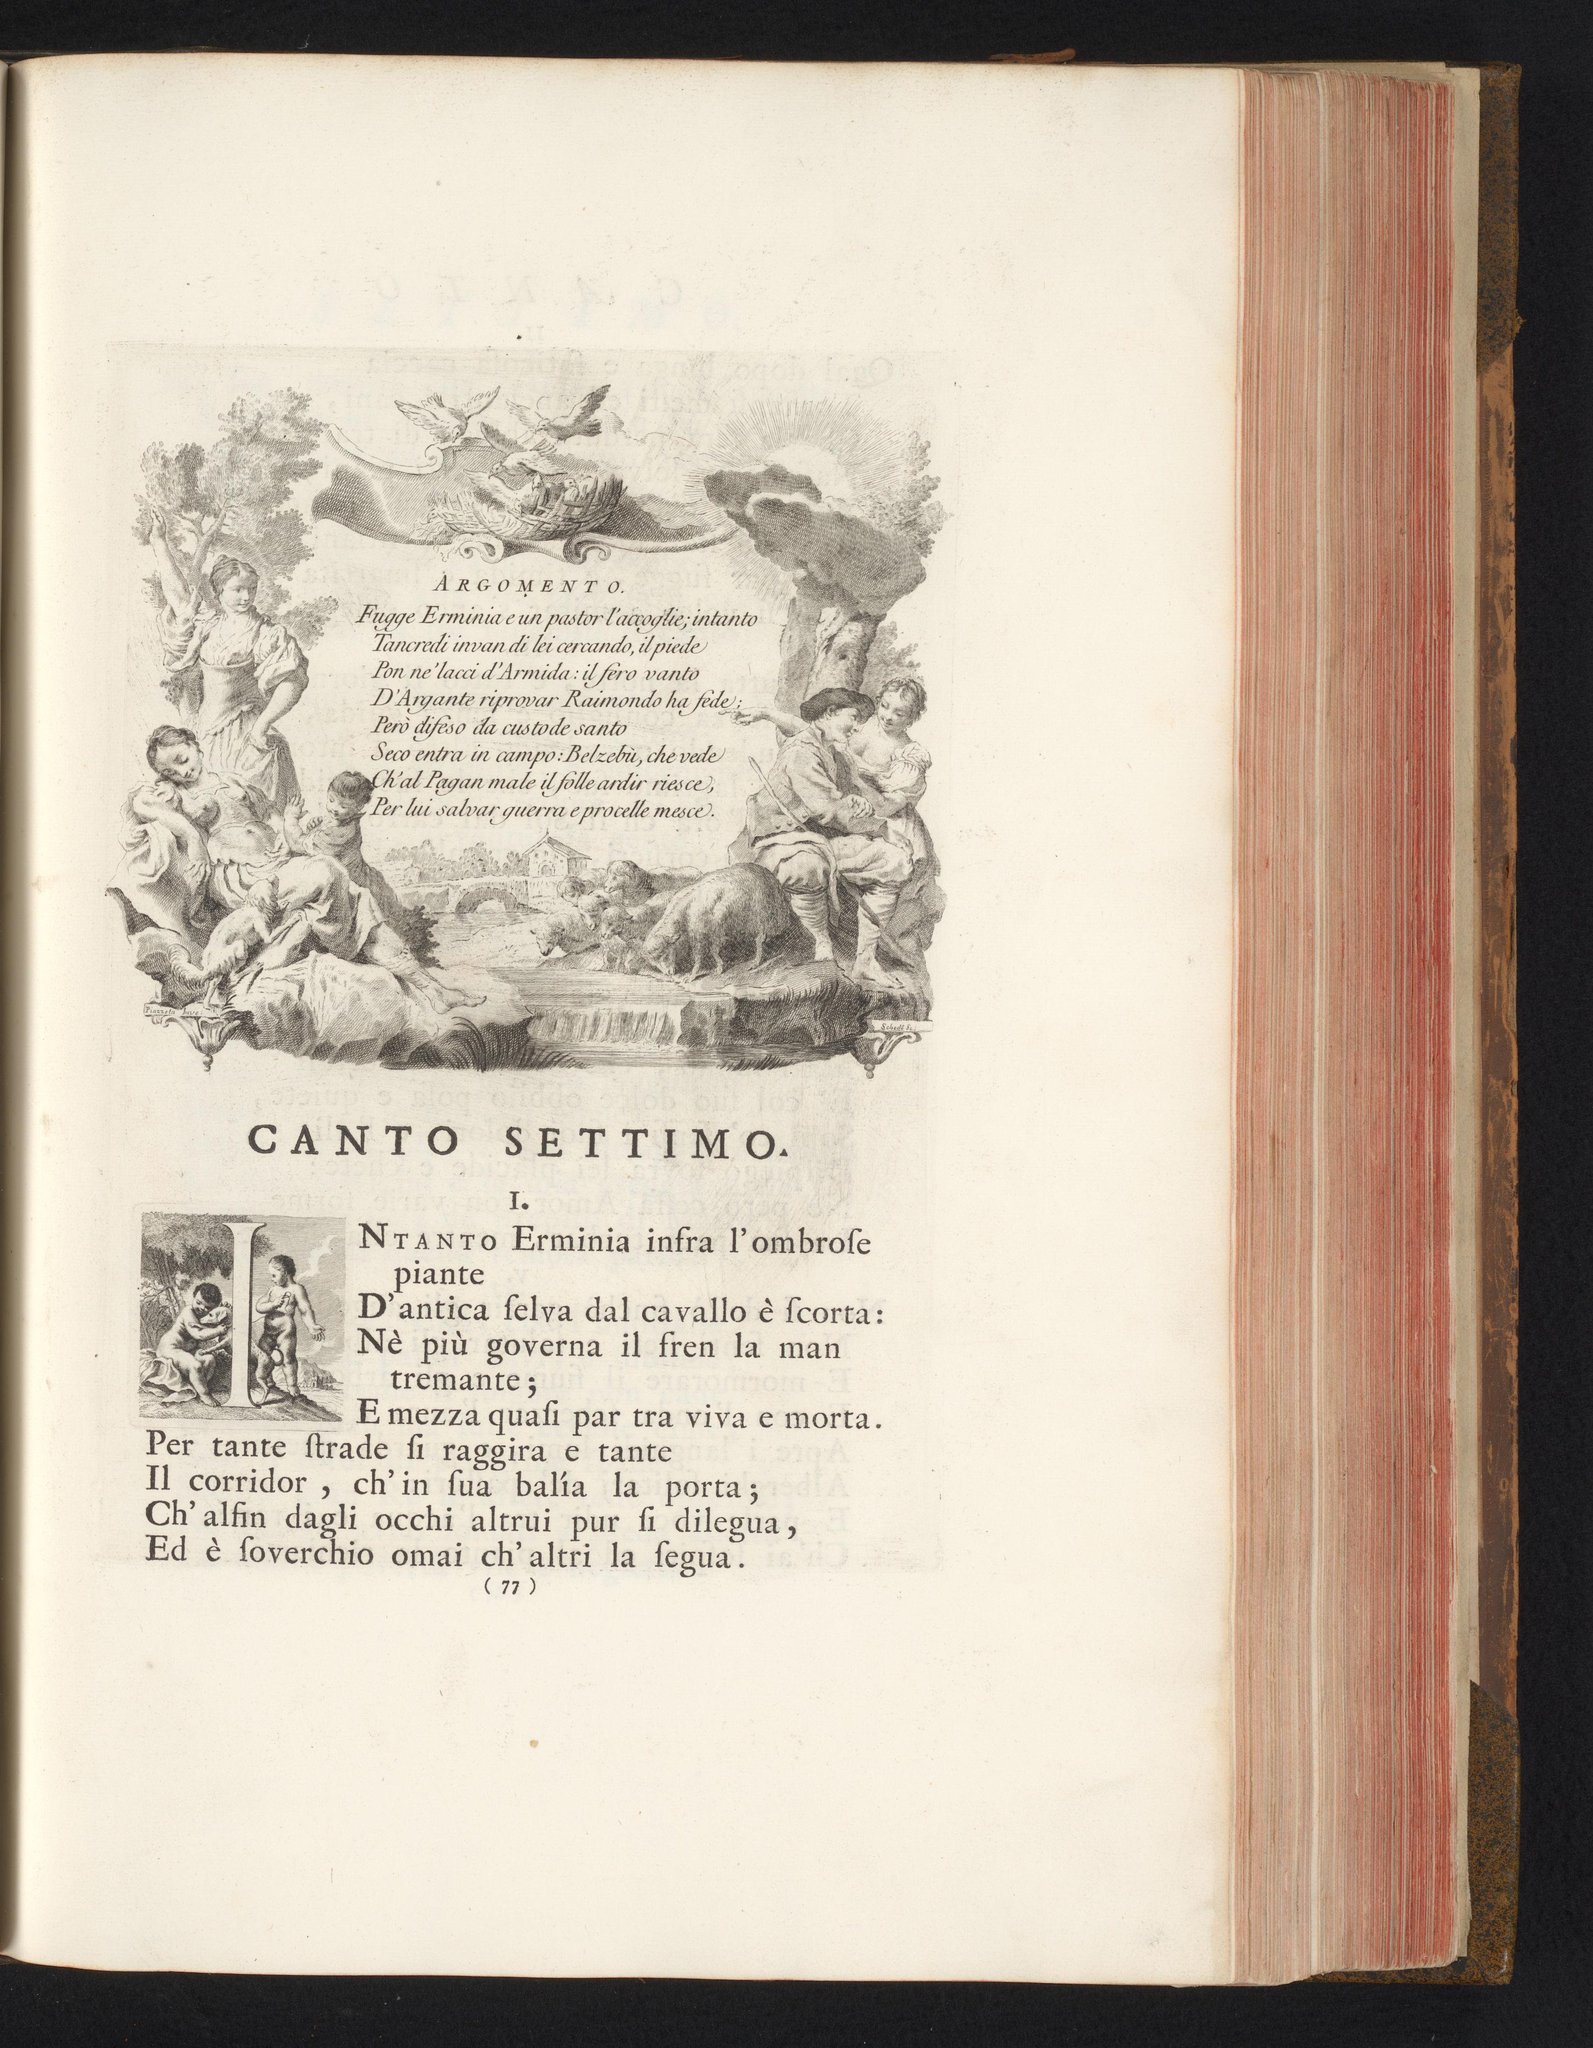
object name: book illustration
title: Pastorale scène en initiaal I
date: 1745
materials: paper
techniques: etching, letterpress printing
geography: venice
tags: herding, herdsman, herdswoman, shepherd, shepherdess, cowherd, etc., initial, (scenes from) specific works of literature: tasso, gerusalemme liberata, pastorals, arcadian scenes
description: Prent uit: Tasso, Torquato. La Gerusalemme liberata di Torquato Tasso con le figure de Giambatista Piazzetta. Venetië: Giambatista Albrizzi, 1745.